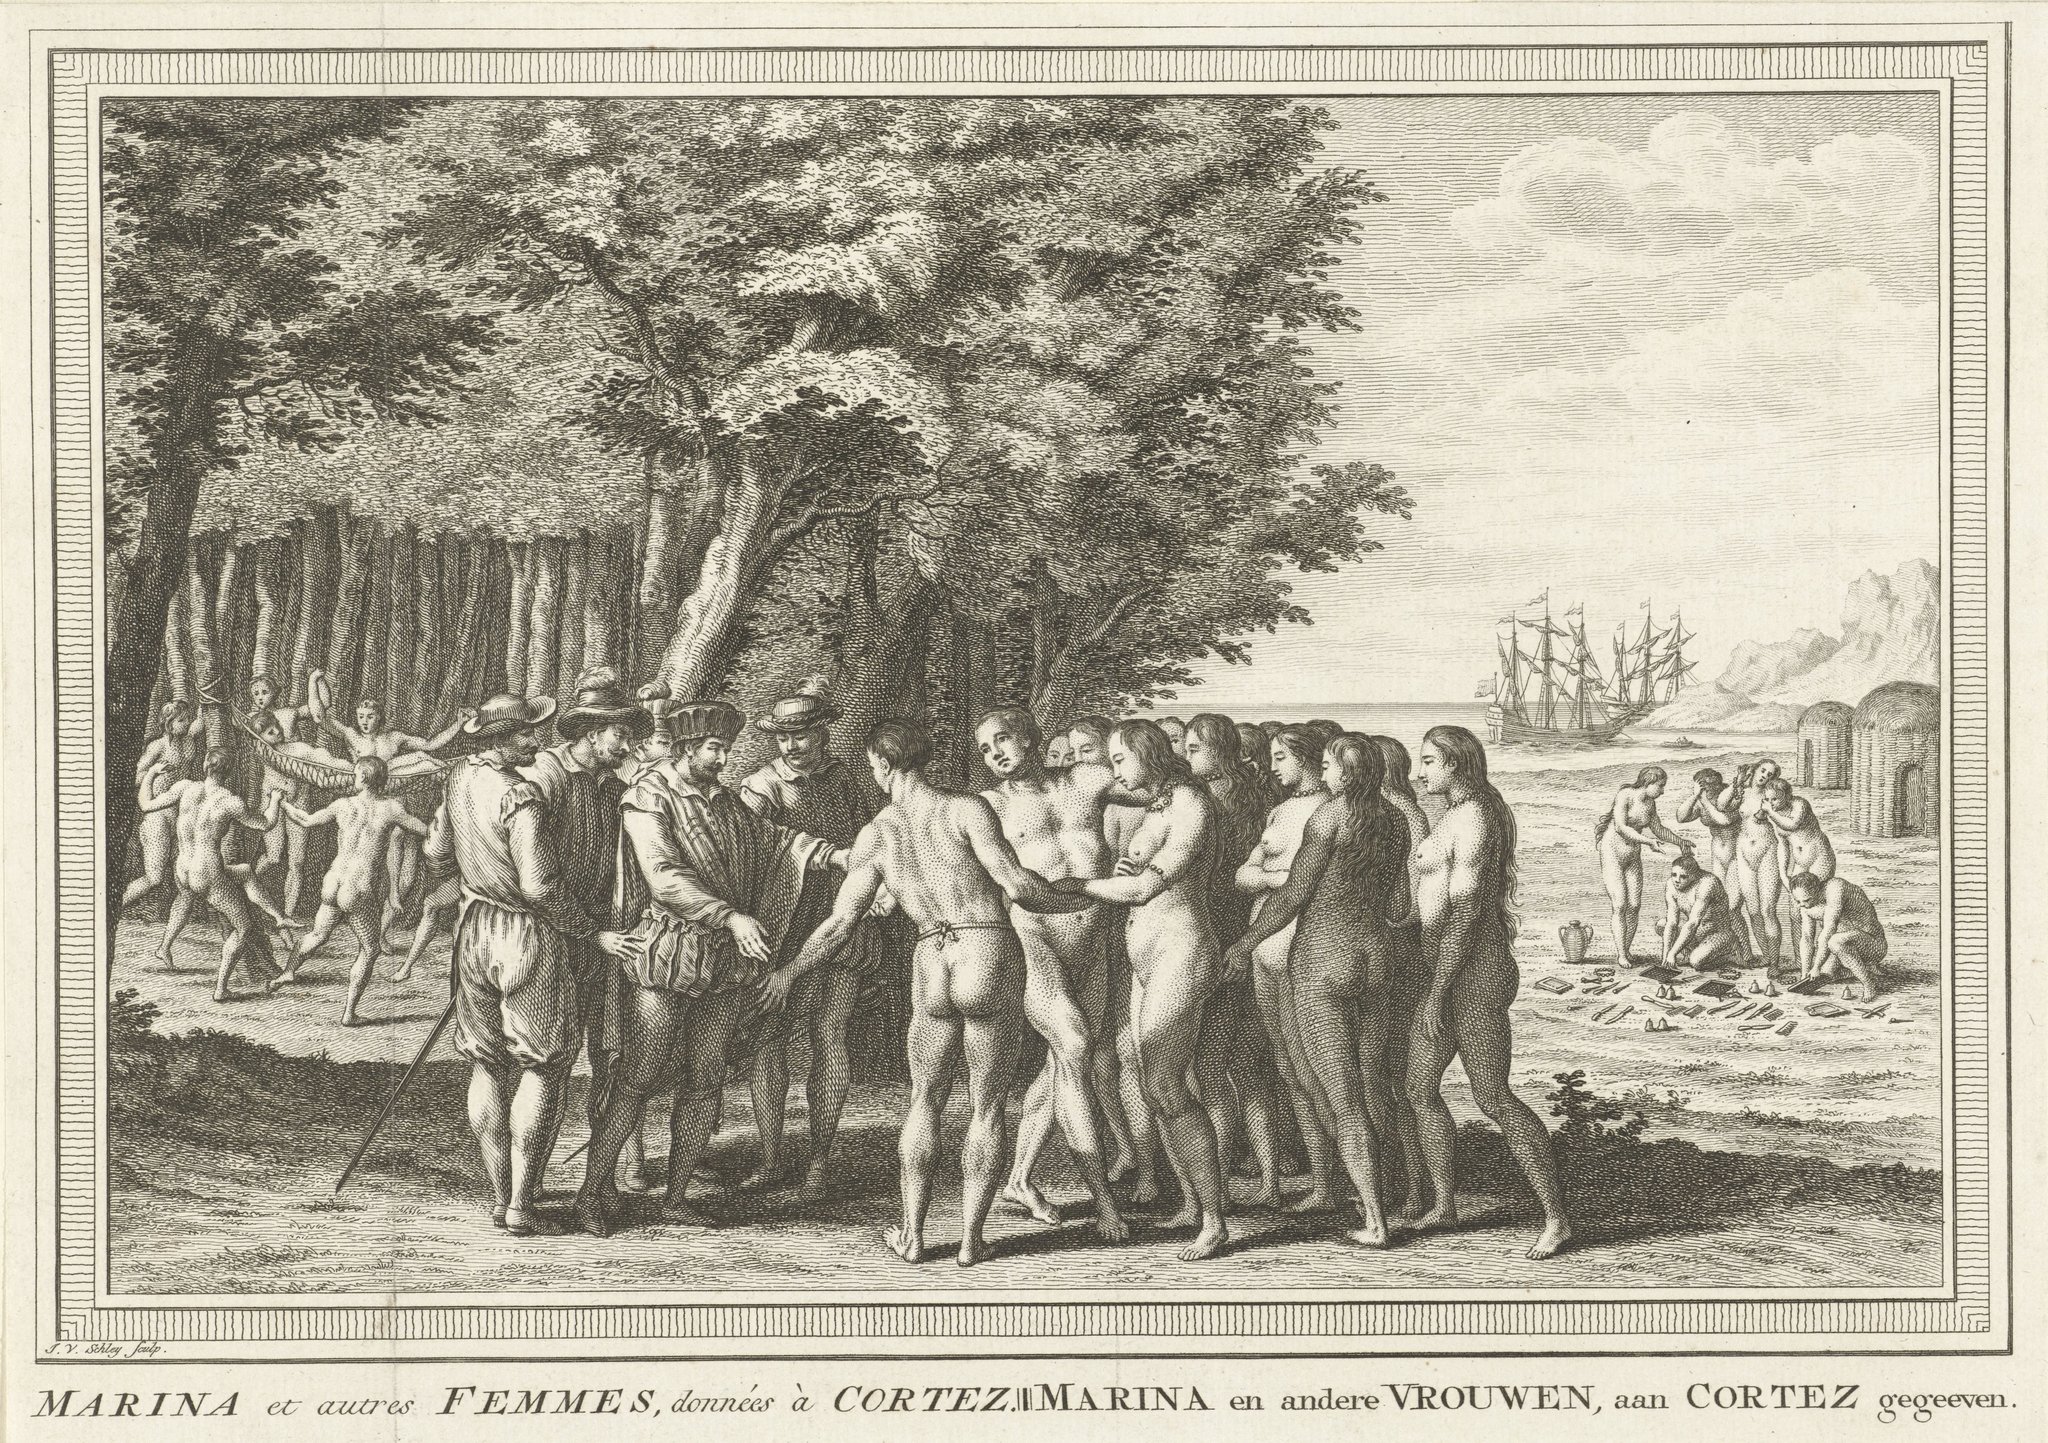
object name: print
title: Marina et autres femmes, données à Cortez / Marina en andere vrouwen, aan Cortez gegeeven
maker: jacob van der schley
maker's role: draughtsman, print maker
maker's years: 1715-1779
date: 1725-1779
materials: paper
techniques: engraving, etching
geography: amsterdam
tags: castilleja de la cuesta, gouverneur, legeraanvoerder, hernán cortés, mexico-stad, malinalli tenépatl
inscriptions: collector's mark: Lugt 2166, collector's mark: Lugt 2760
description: Marina wordt samen met negentien andere Azteekse vrouwen door een Maya-hoofdman geschonken aan de Spaanse ontdekkingsreiziger en veroveraar Hernán Cortés (ook wel Fernand Cortez genoemd), 1519. Marina, ook wel bekend als la Malinche, werd later de geliefde van Cortés. Op de achtergrond danst een groep mannen rond een hangmat. Rechts de vloedlijn, enkele hutten en mensen met sieraden en kammen.